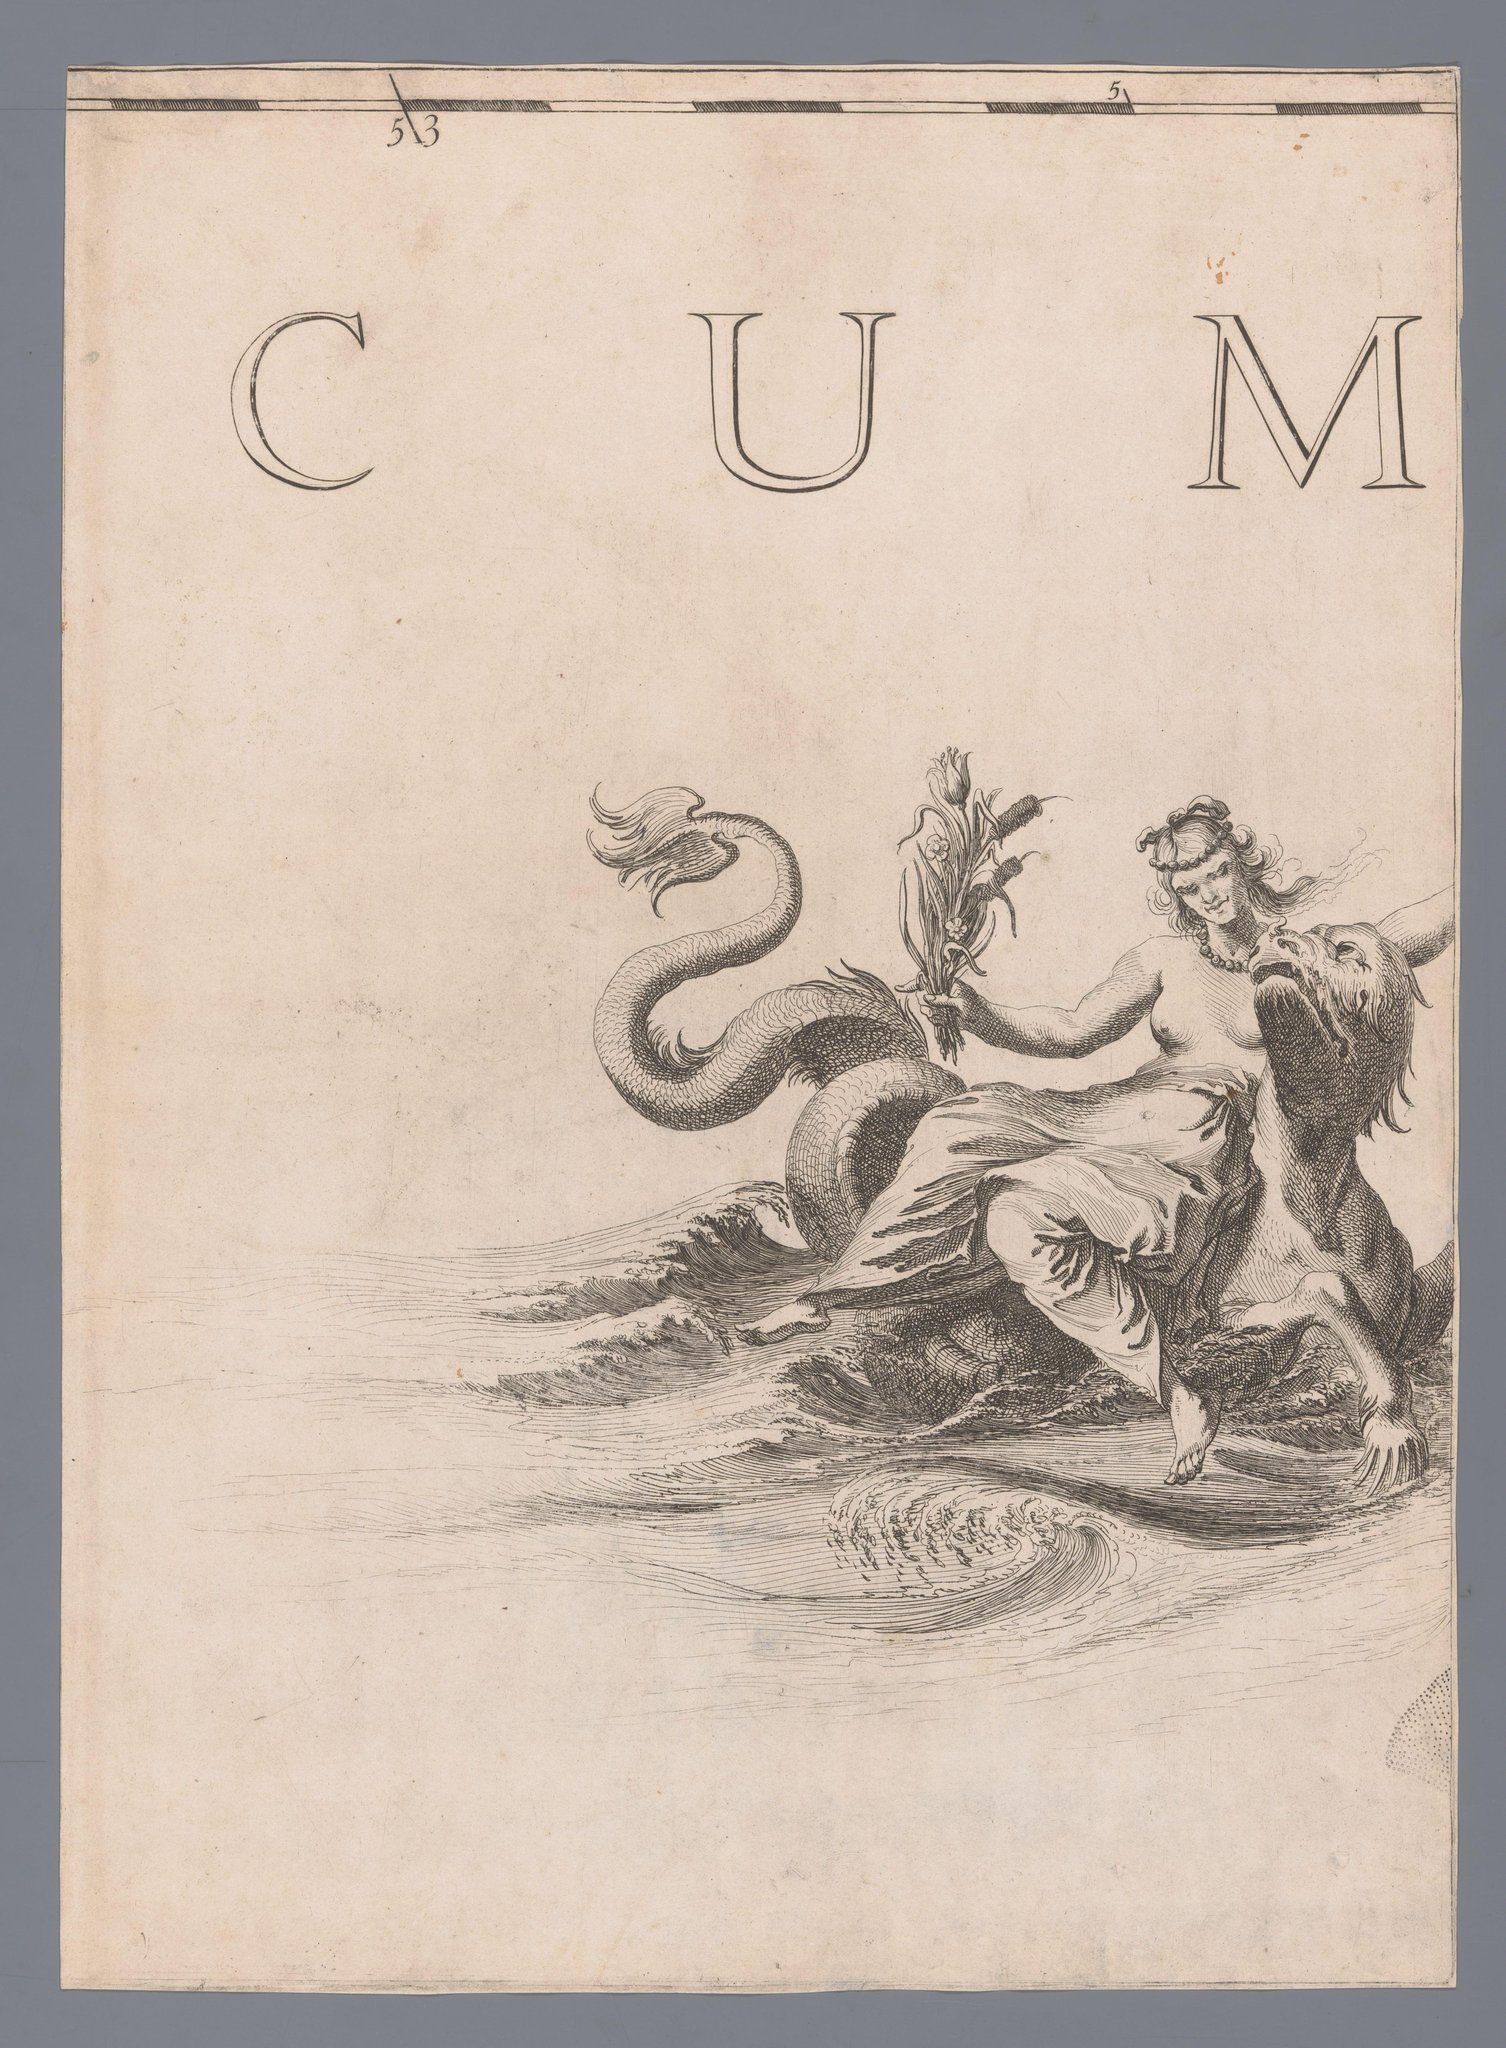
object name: print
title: Kaart van het Graafschap Holland en Utrecht (plaat 3)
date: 1639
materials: paper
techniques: engraving, etching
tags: maps, atlases, gods of the waters: neptune and his environment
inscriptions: collector's mark: Lugt 2228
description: Onderdeel van een kaart samengesteld uit 40 bladen. Waarschijnlijk gaat het om de grootste kaart van Holland uit de zeventiende-eeuw. De kaart is uitgegeven in verschillende edities, deze kaart uit 1639 is de eerste editie.